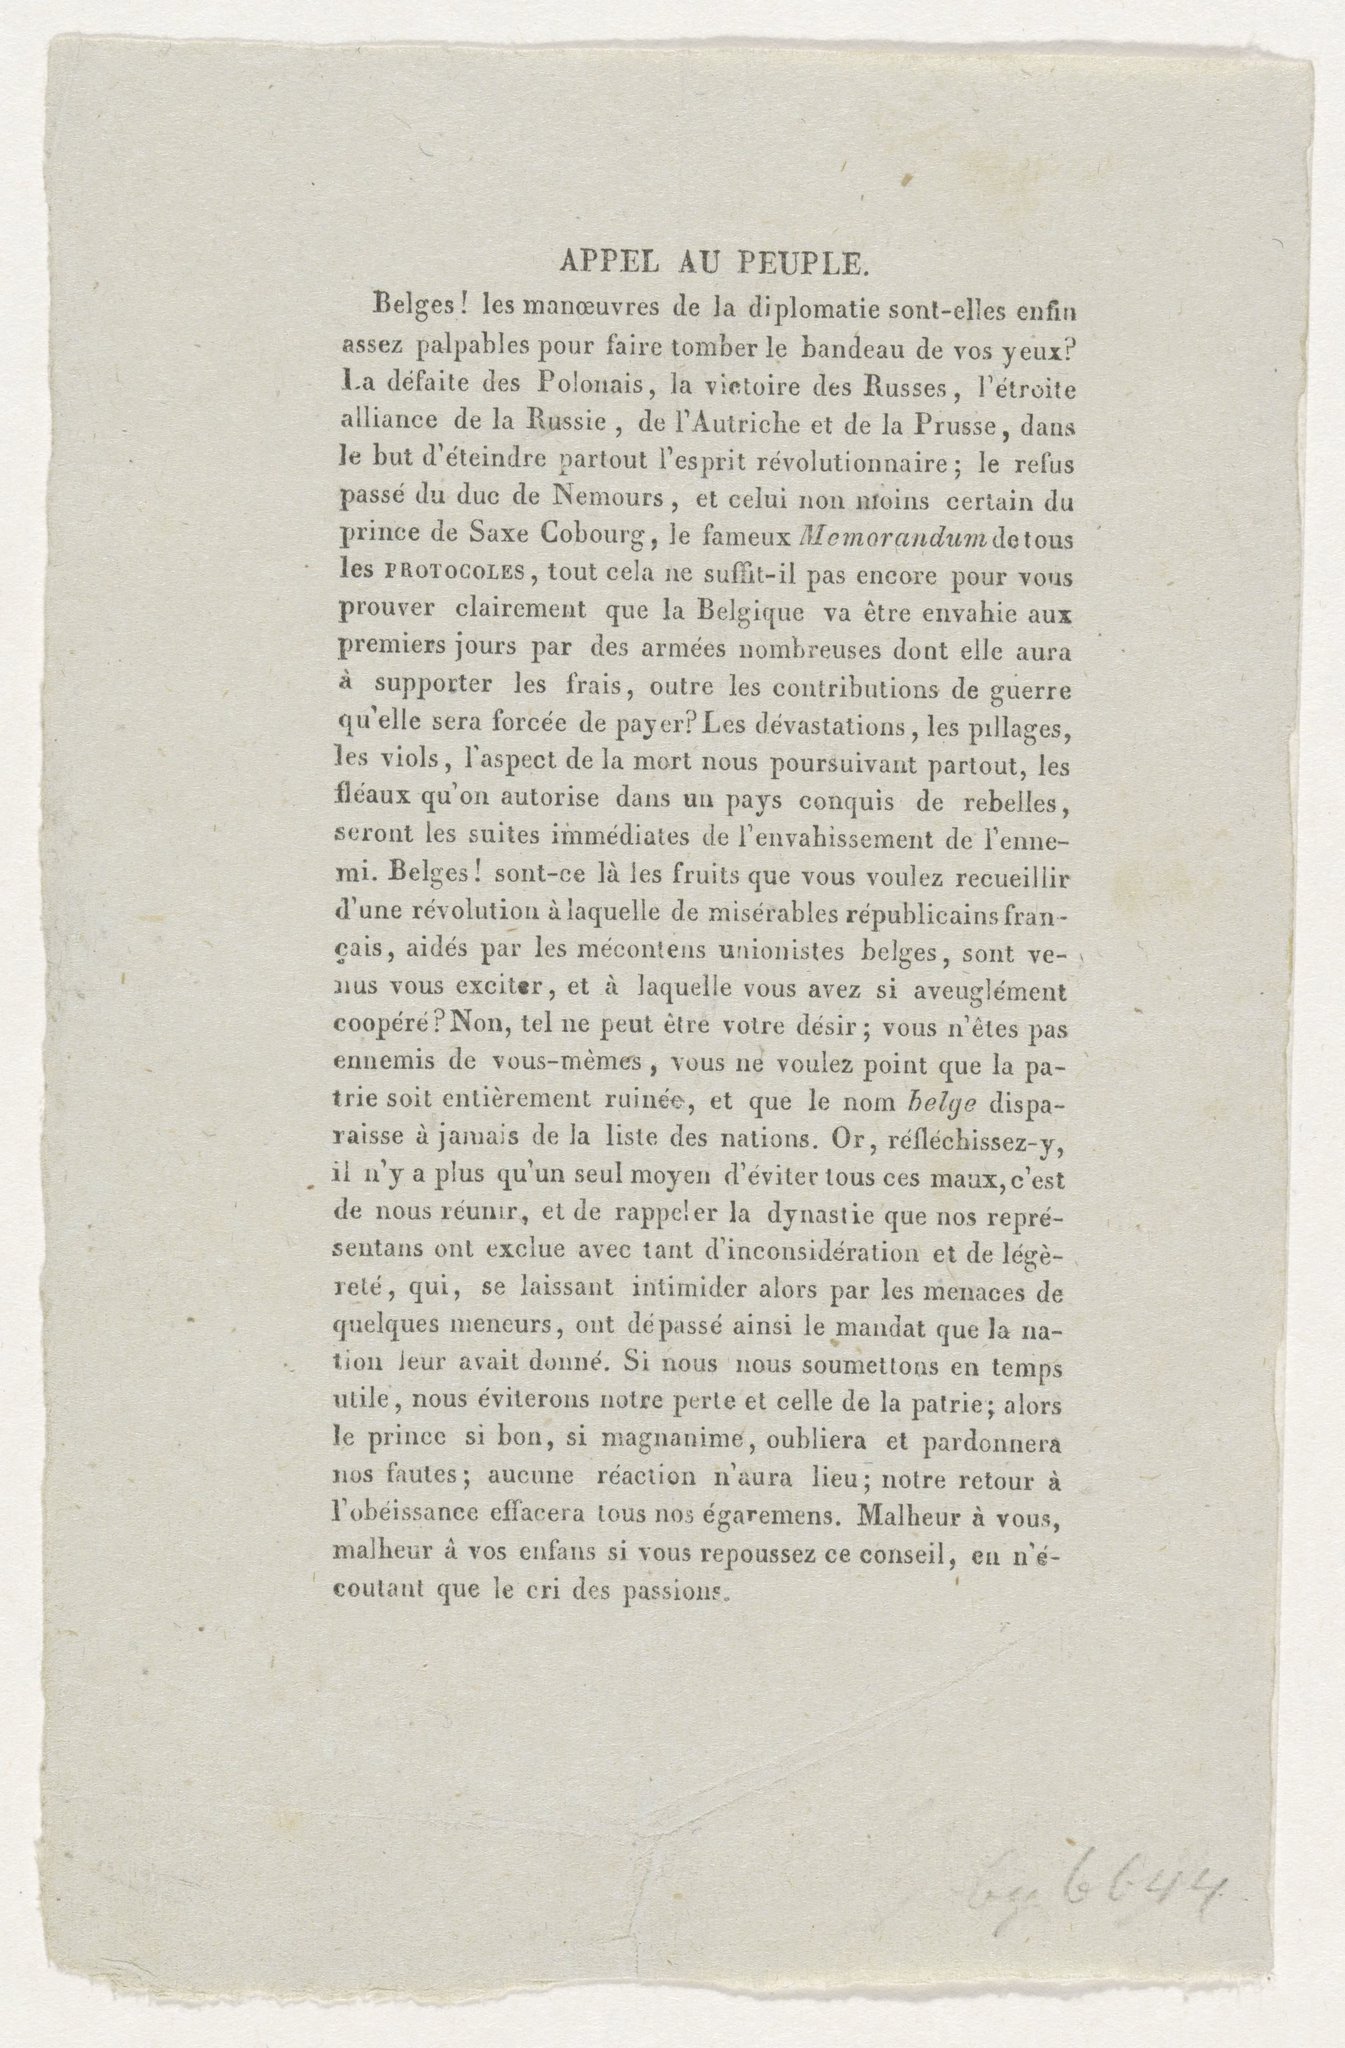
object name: text sheet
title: Appel au peuple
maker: Anonymous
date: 1831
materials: paper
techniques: letterpress printing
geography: netherlands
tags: koningskeuze in belgië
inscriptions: collector's mark: Lugt 2228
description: Strooibiljet met tekst in het Frans aangaande de diplomatieke onderhandelingen over de keuze van een Belgische koning, februari 1831. De inhoud is ten gunste van het Huis van Oranje.